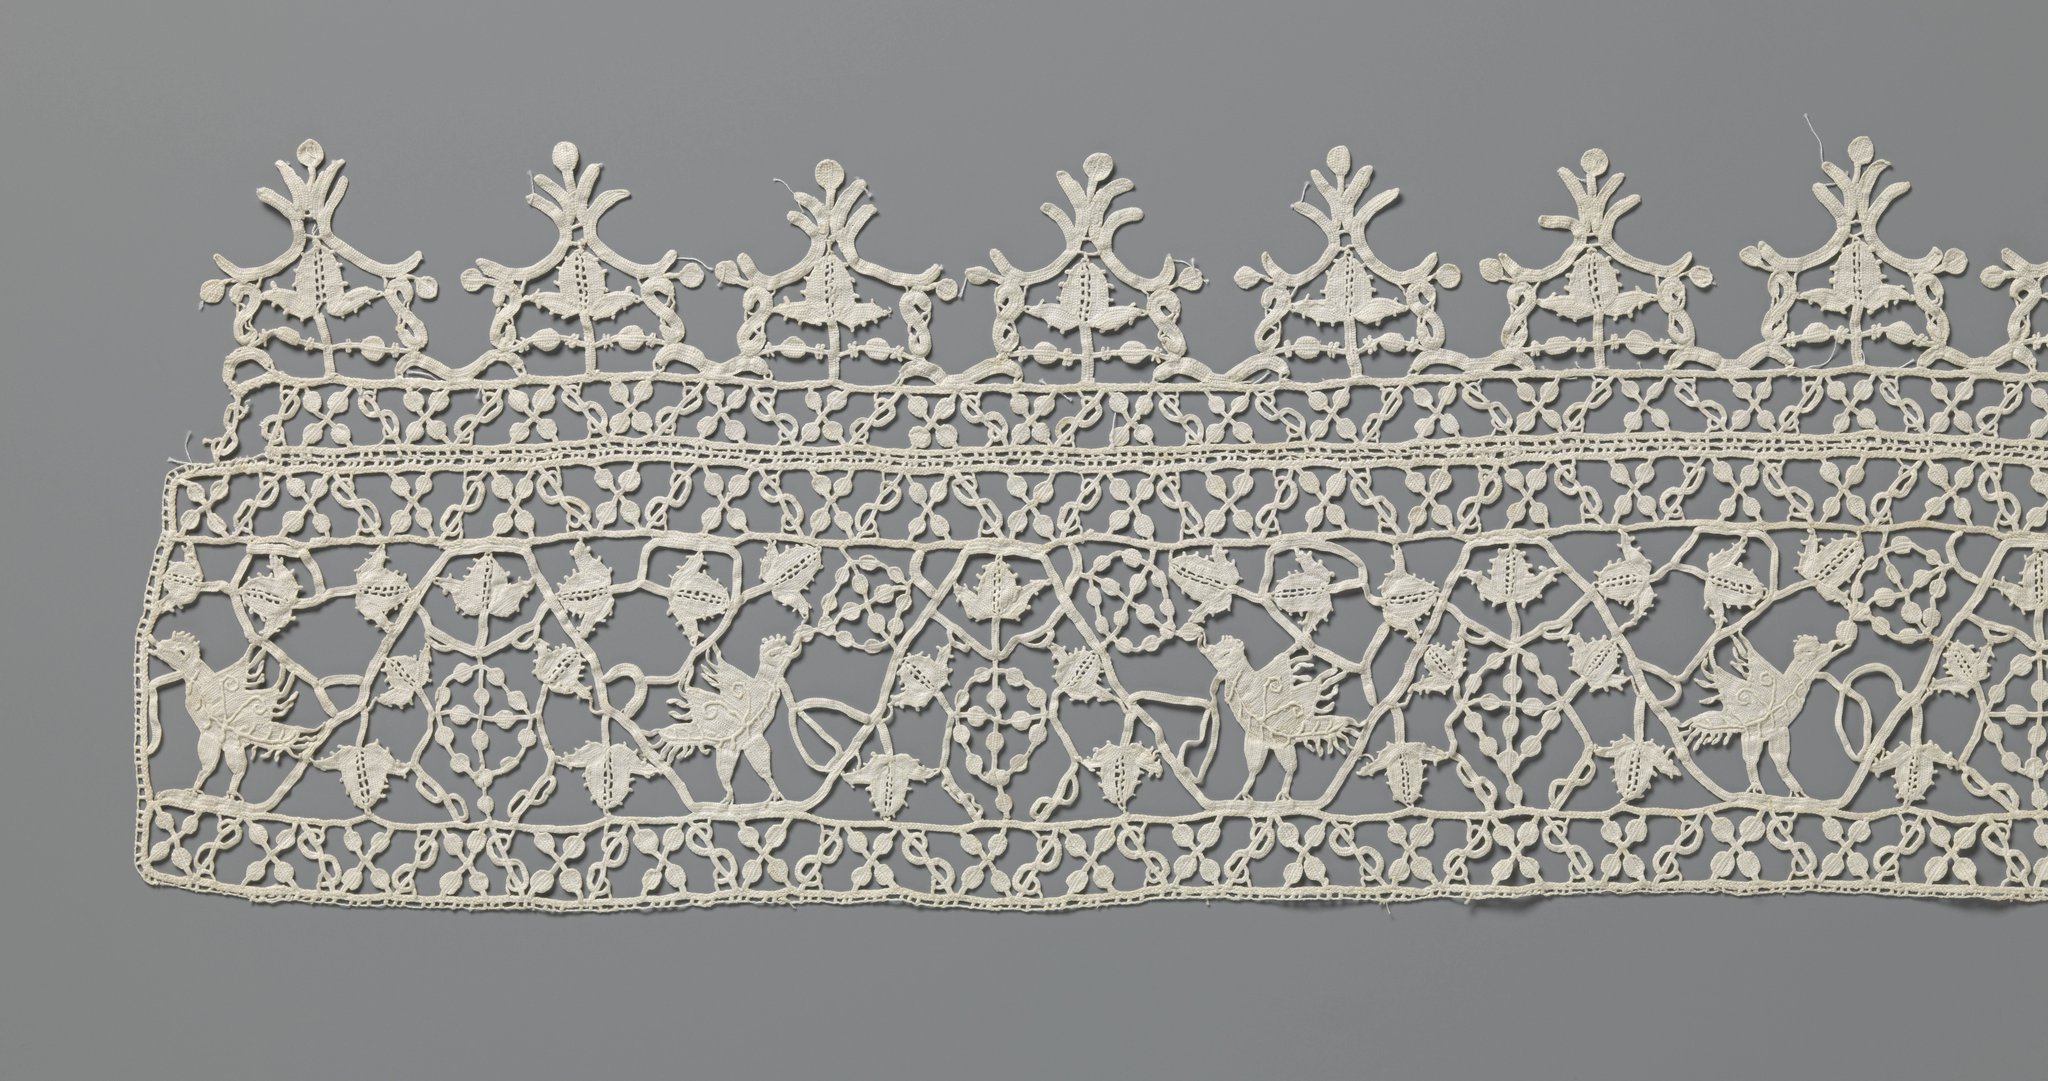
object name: strip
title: Border with Birds and Bunches of Grapes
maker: Anonymous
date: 1600-1620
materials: linen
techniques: needle lace, punto in aria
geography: italy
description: The Venetian engraver Cesare Vecellio published four patterns books with lace motifs between 1592 and 1608. The border with birds eating grapes is close, but not identical to any specific pattern in this book.